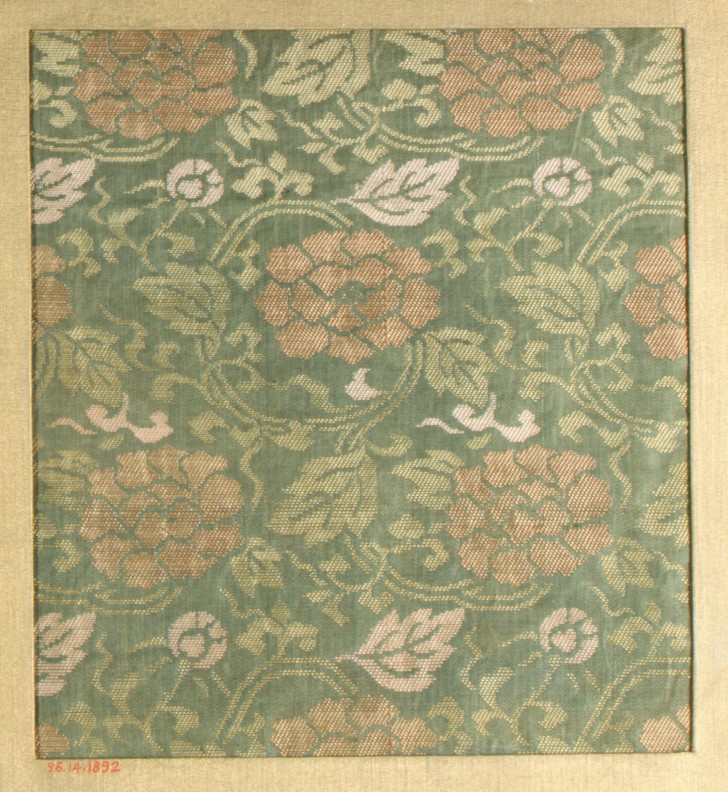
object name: piece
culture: japanese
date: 1701-1900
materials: silk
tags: leaves